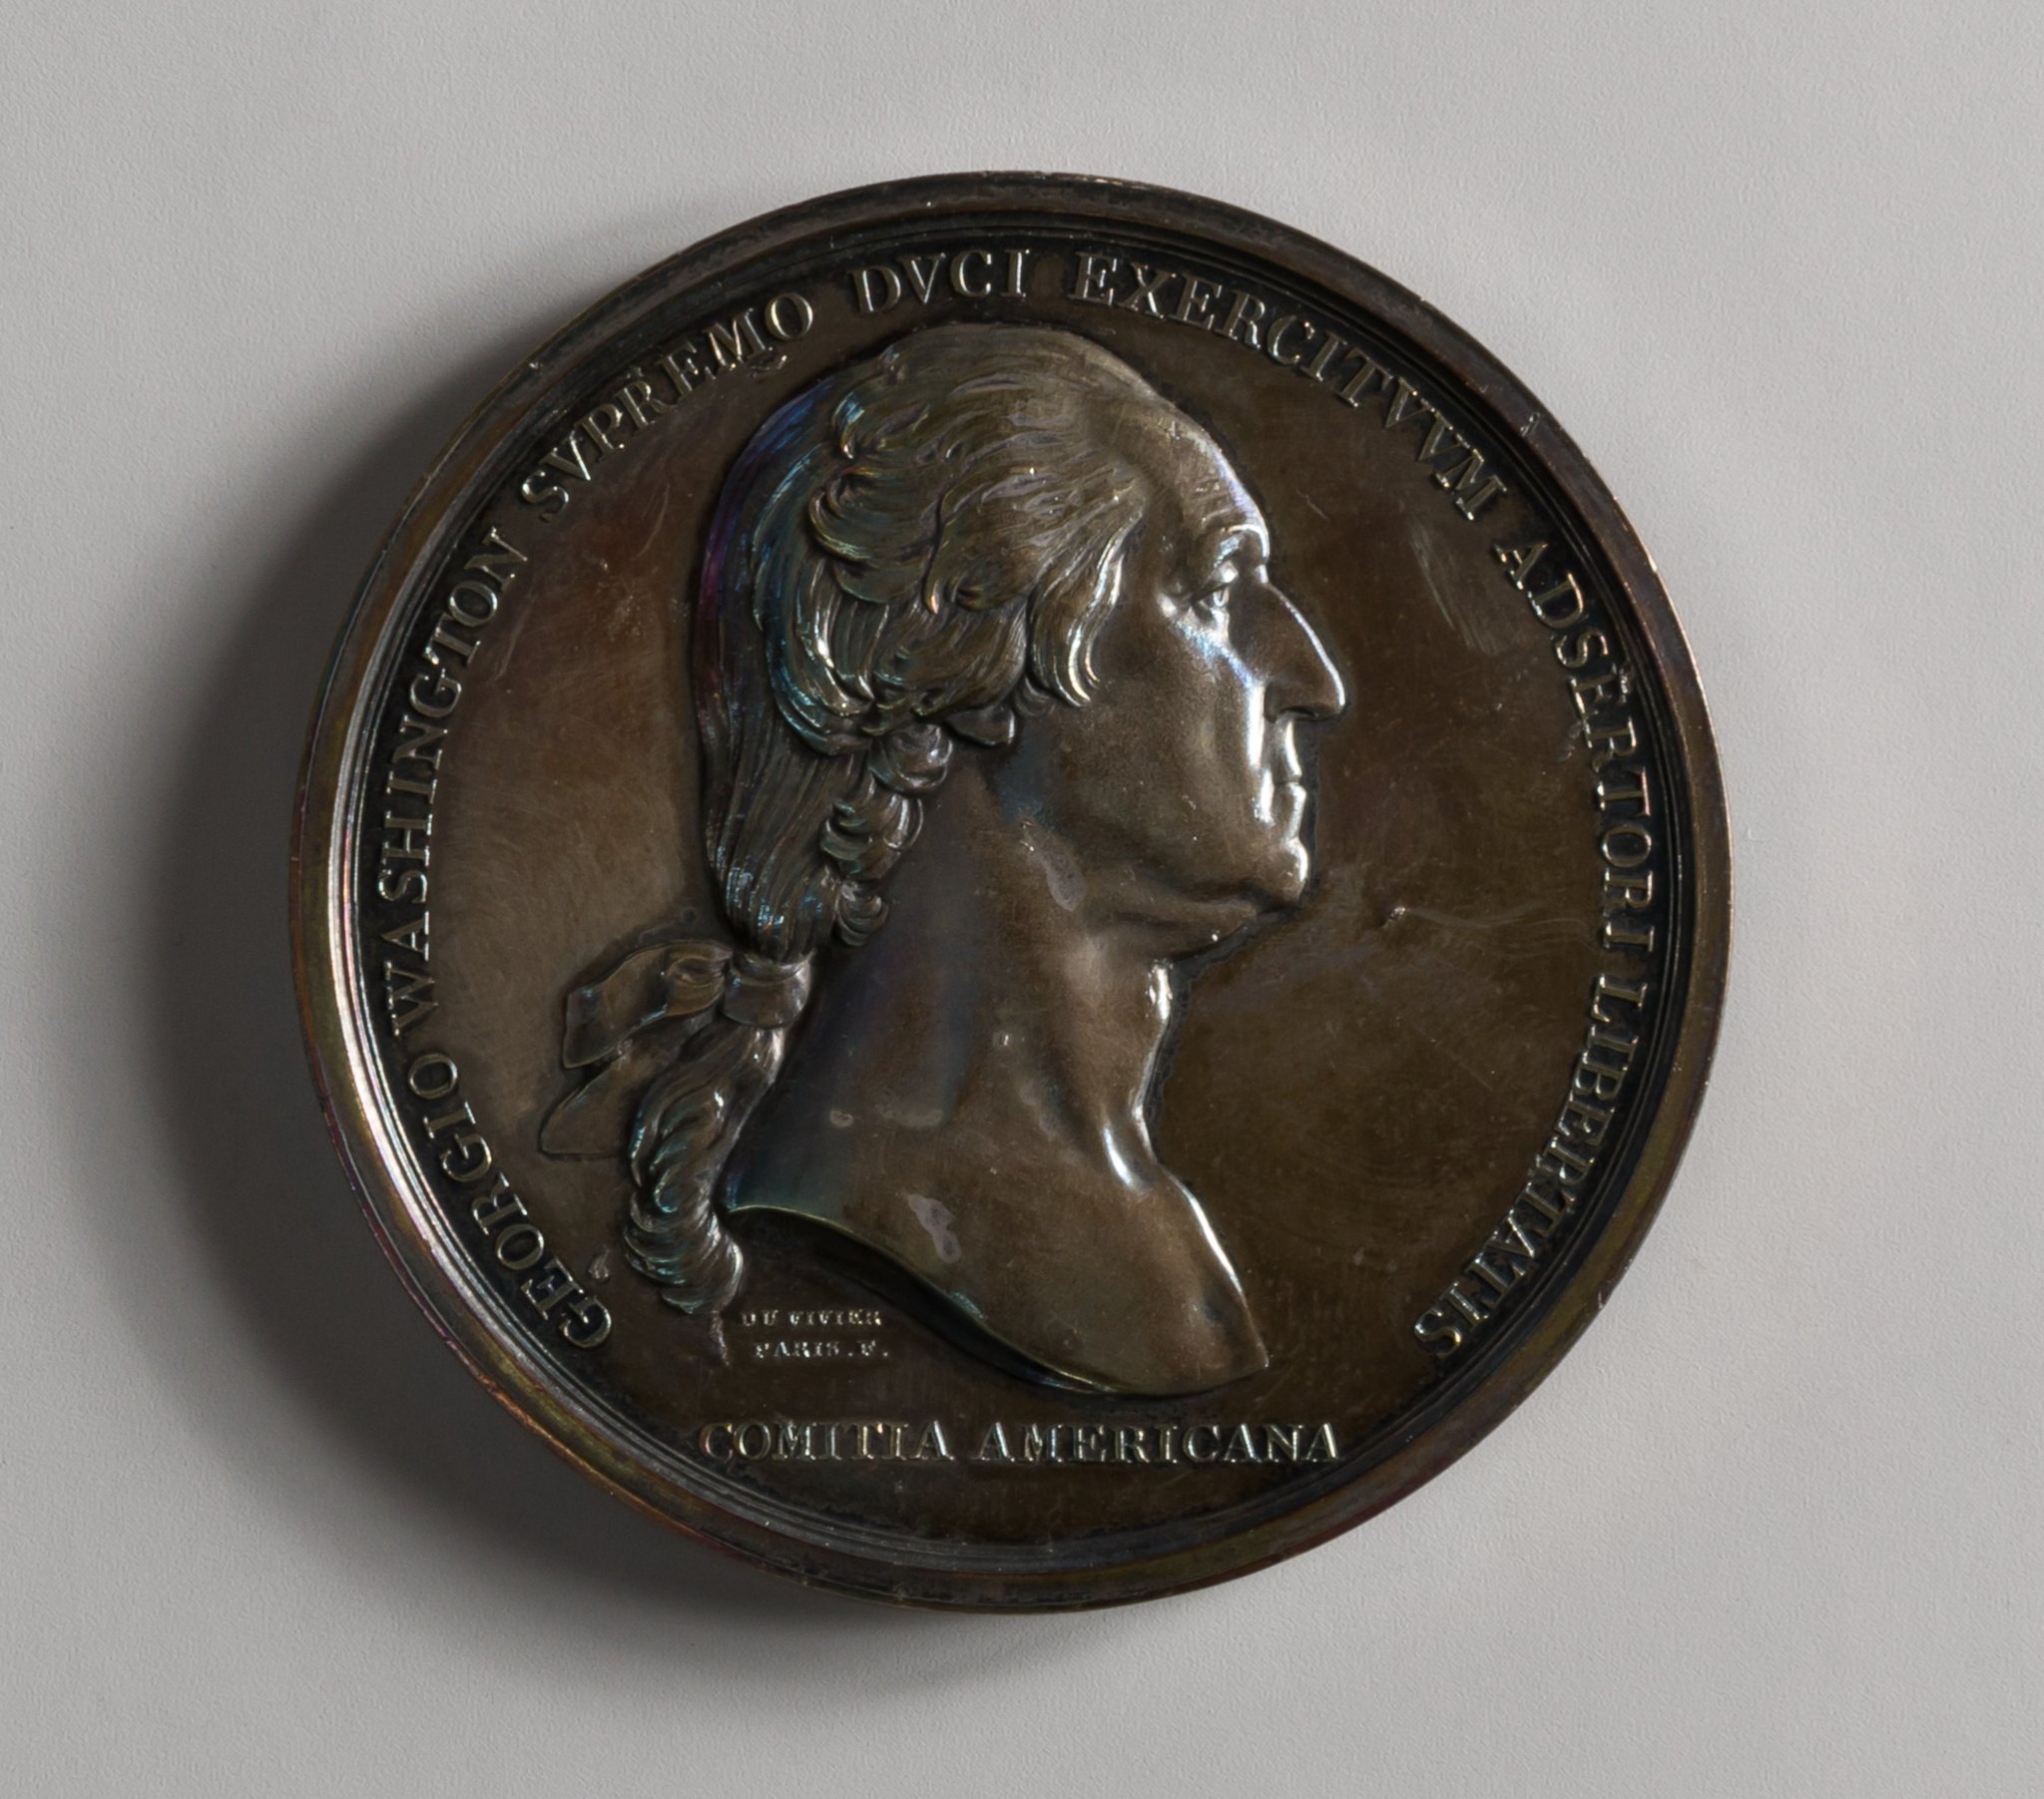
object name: medal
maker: pierre simon benj. duvivier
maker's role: maker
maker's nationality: french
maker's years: 1730-1819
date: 1770-1800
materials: silver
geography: france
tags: george washington,portraits,profiles